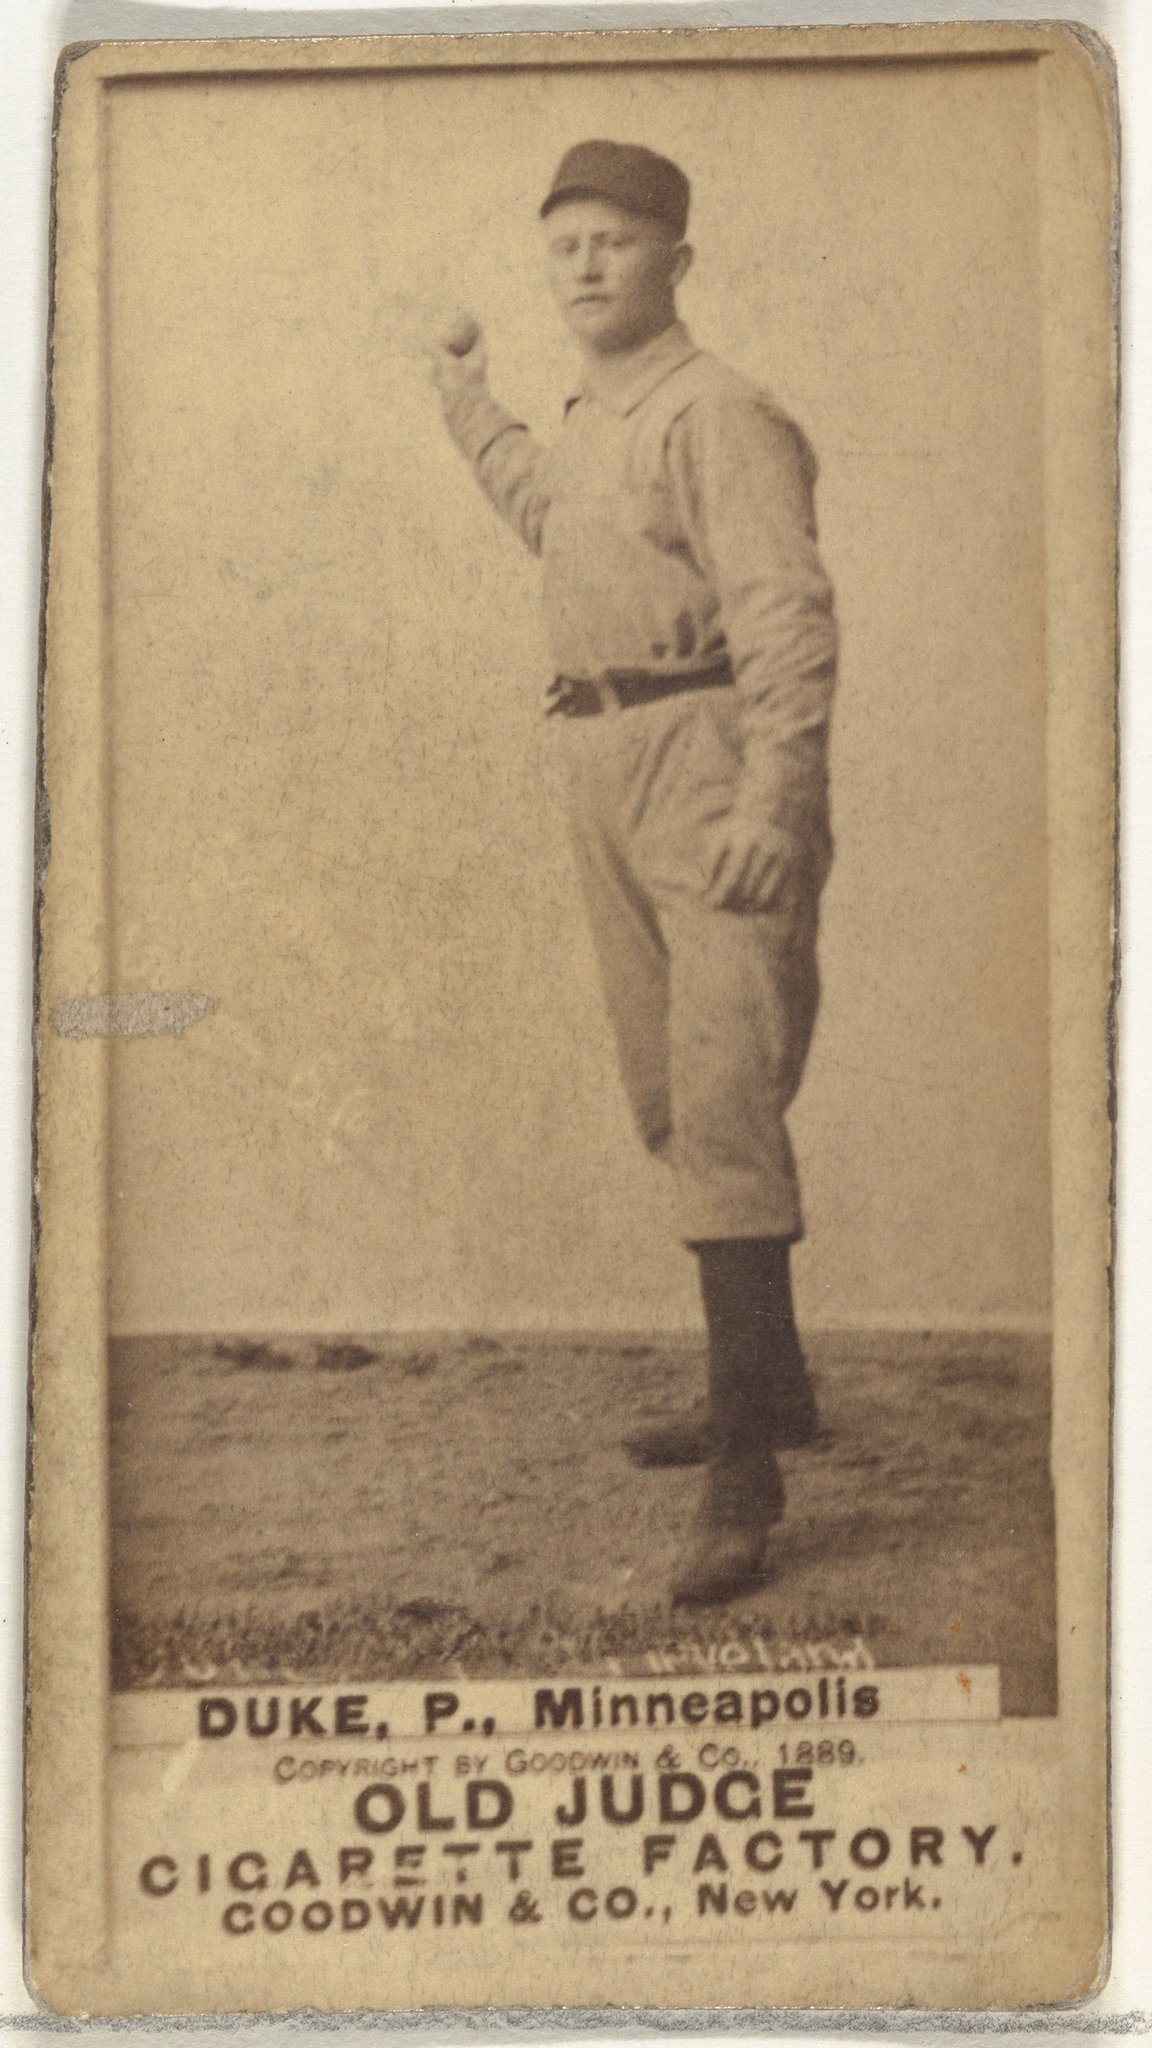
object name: baseball card, photograph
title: Martin F. "Duck" Duke, Pitcher, Minneapolis, from the Old Judge series (N172) for Old Judge Cigarettes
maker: goodwin & company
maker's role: publisher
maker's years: 1850-1950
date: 1889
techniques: albumen silver print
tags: men,portraits,baseball,athletes